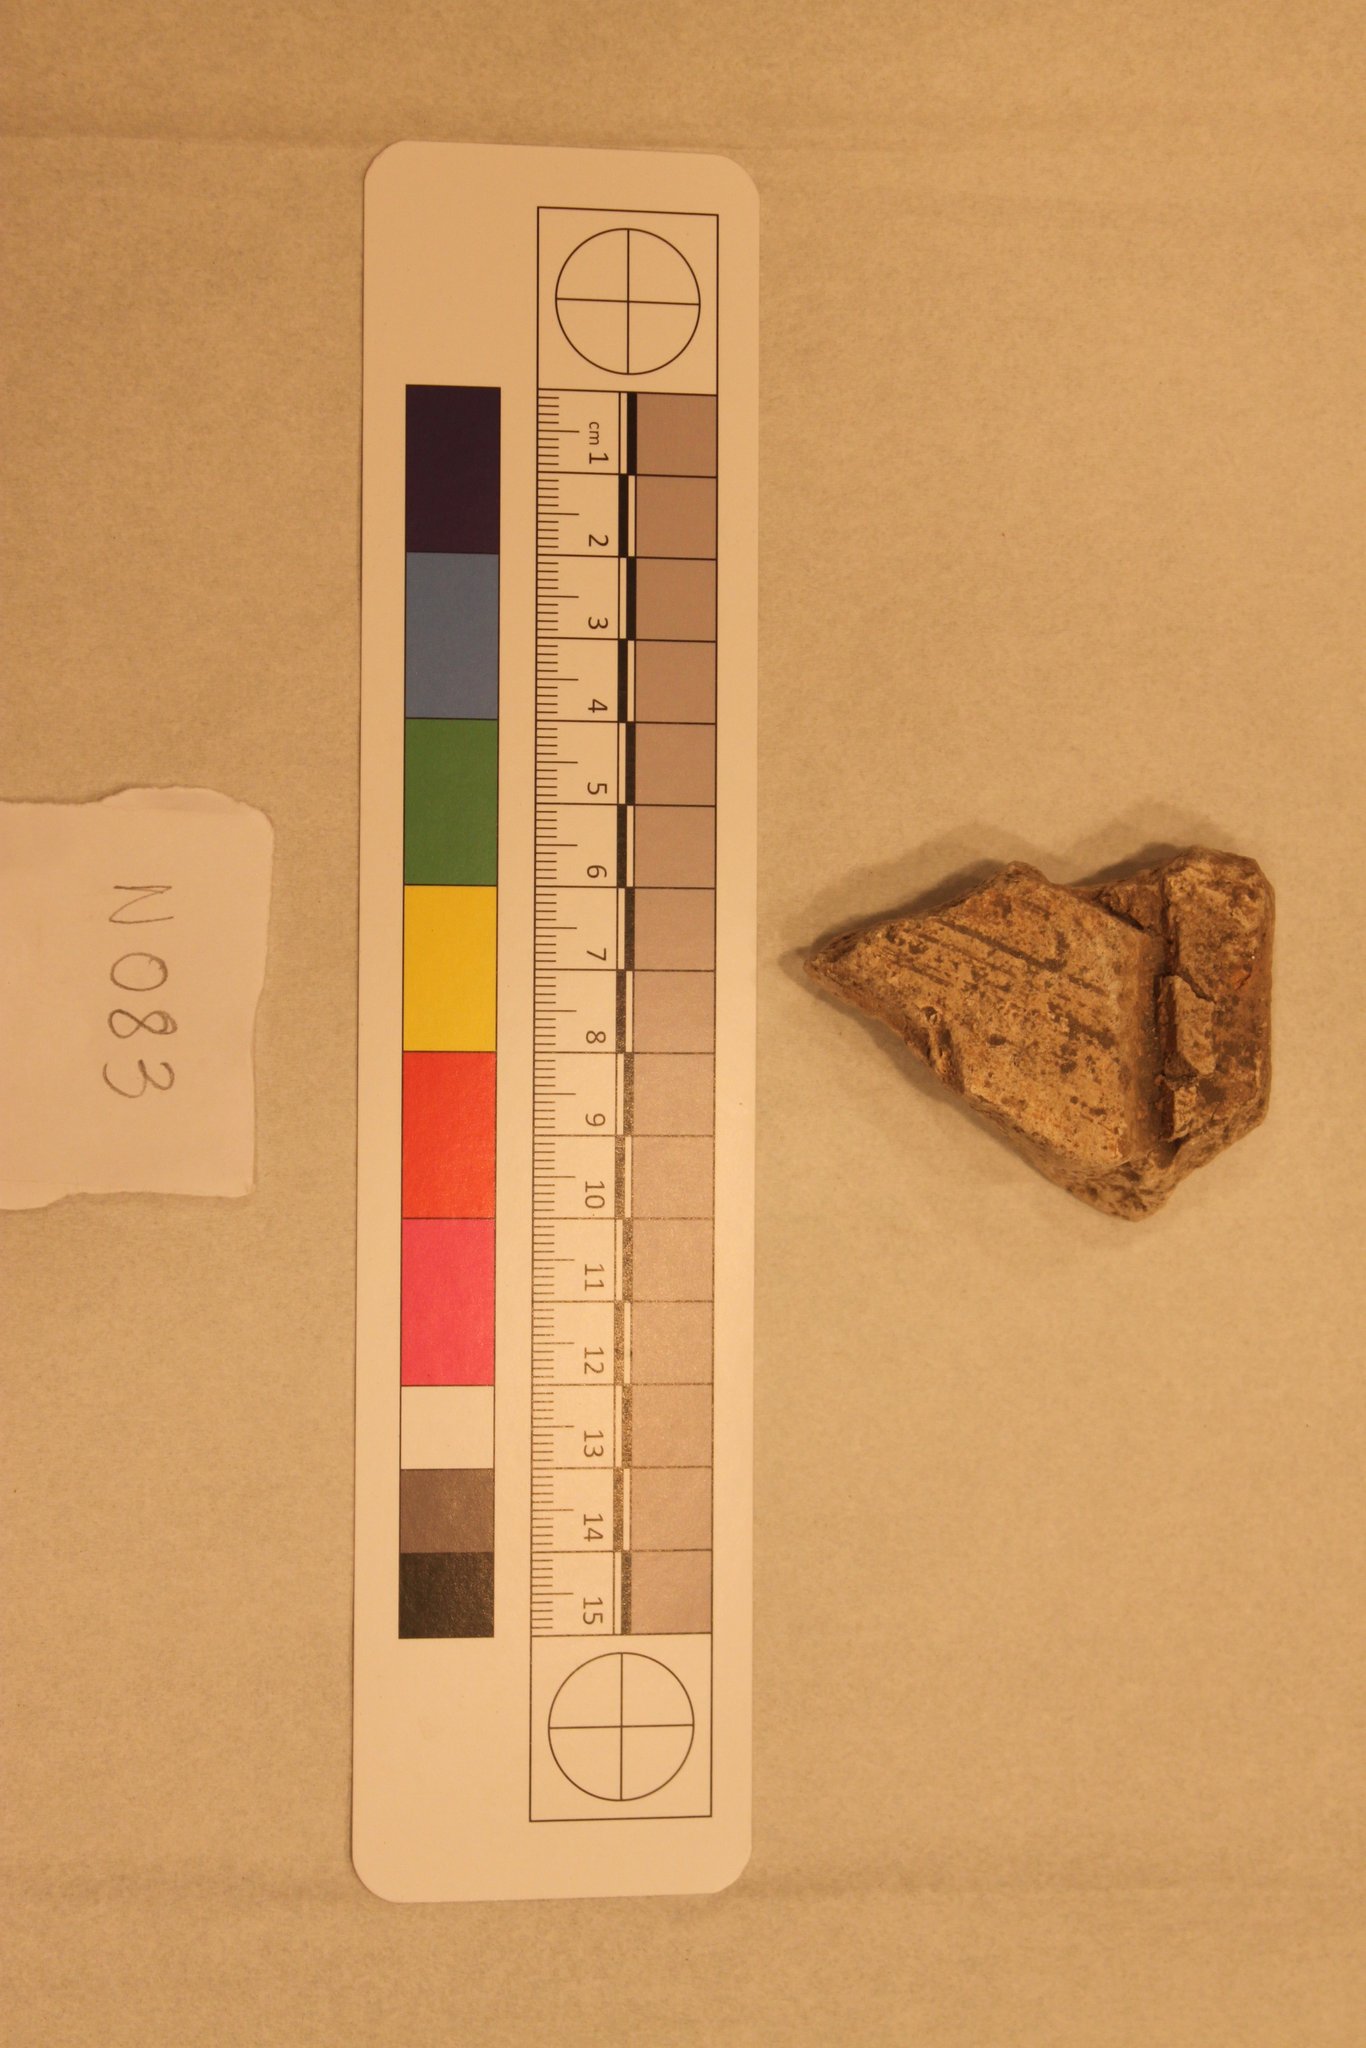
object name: fragment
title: Stucco Fragment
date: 701-1200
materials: plaster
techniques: carving, painting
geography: iran